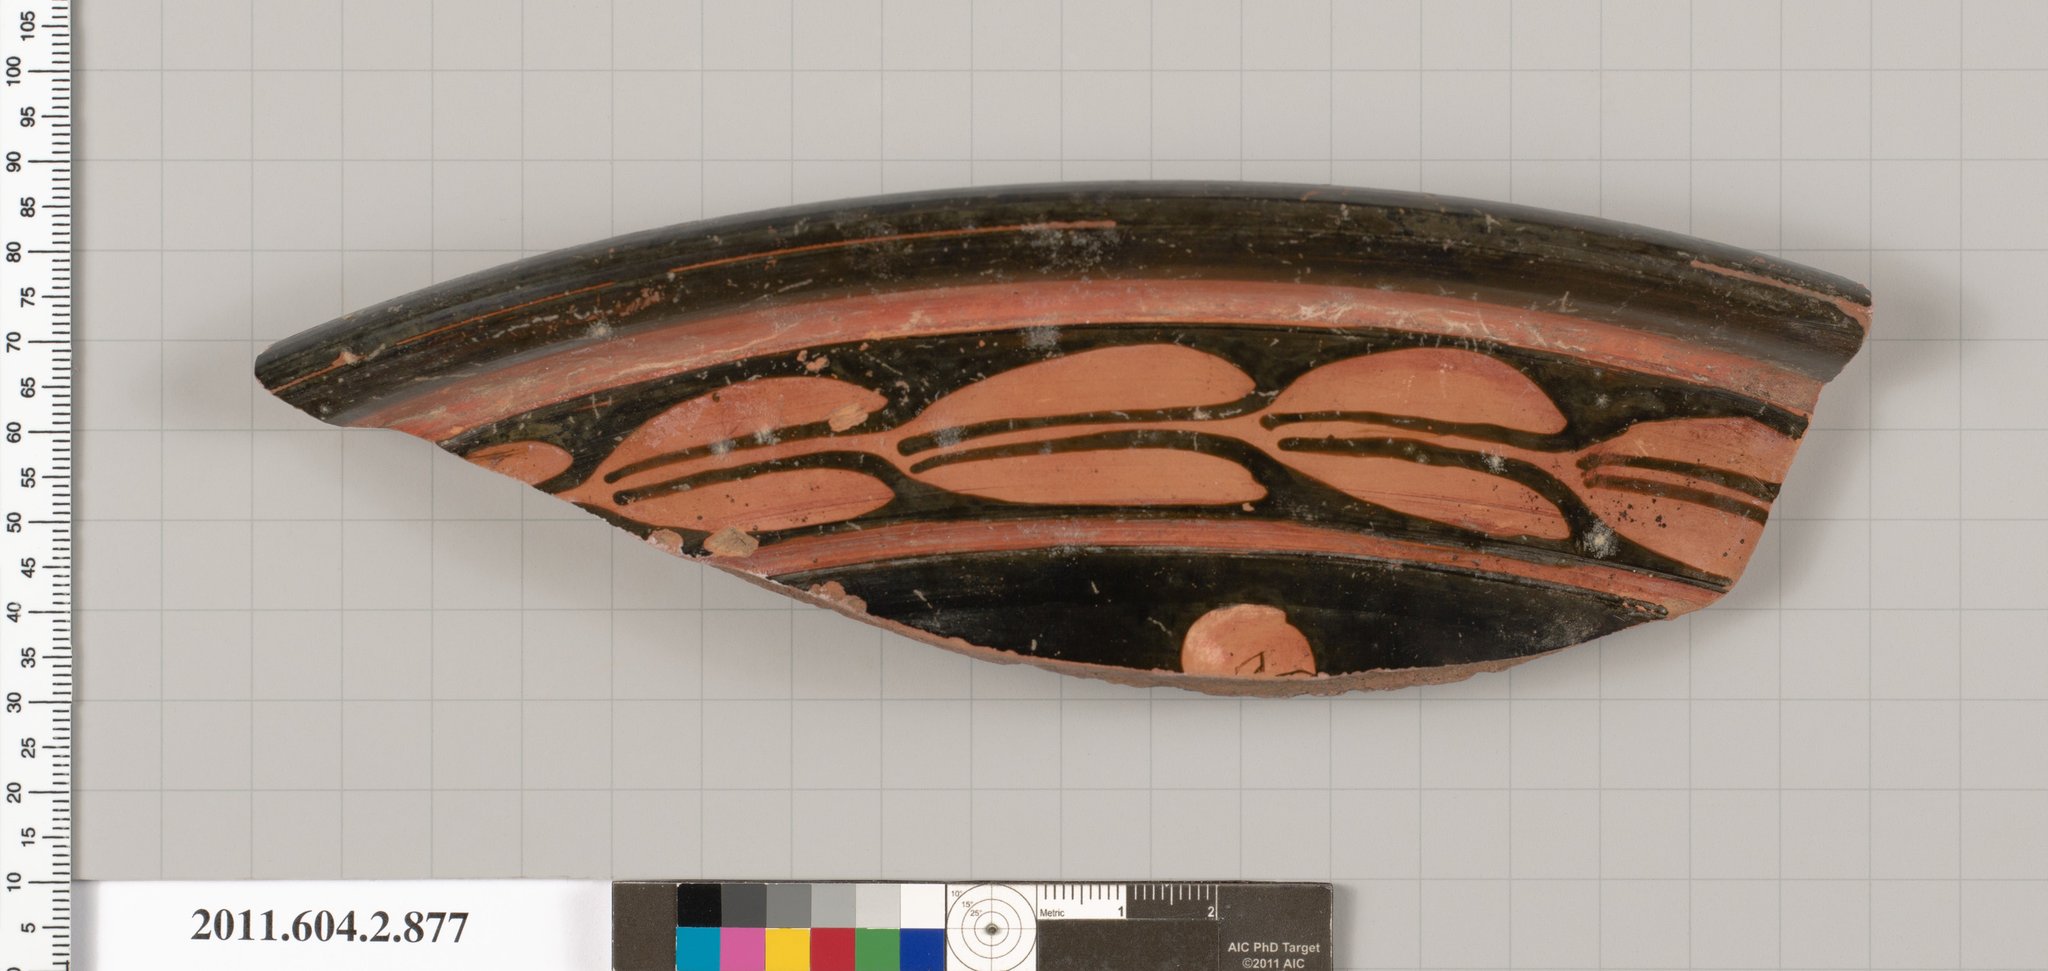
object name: bell krater fragment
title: Terracotta fragment of a bell-krater (bowl for mixing wine and water)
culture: greek, attic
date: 450-426 BCE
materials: terracotta